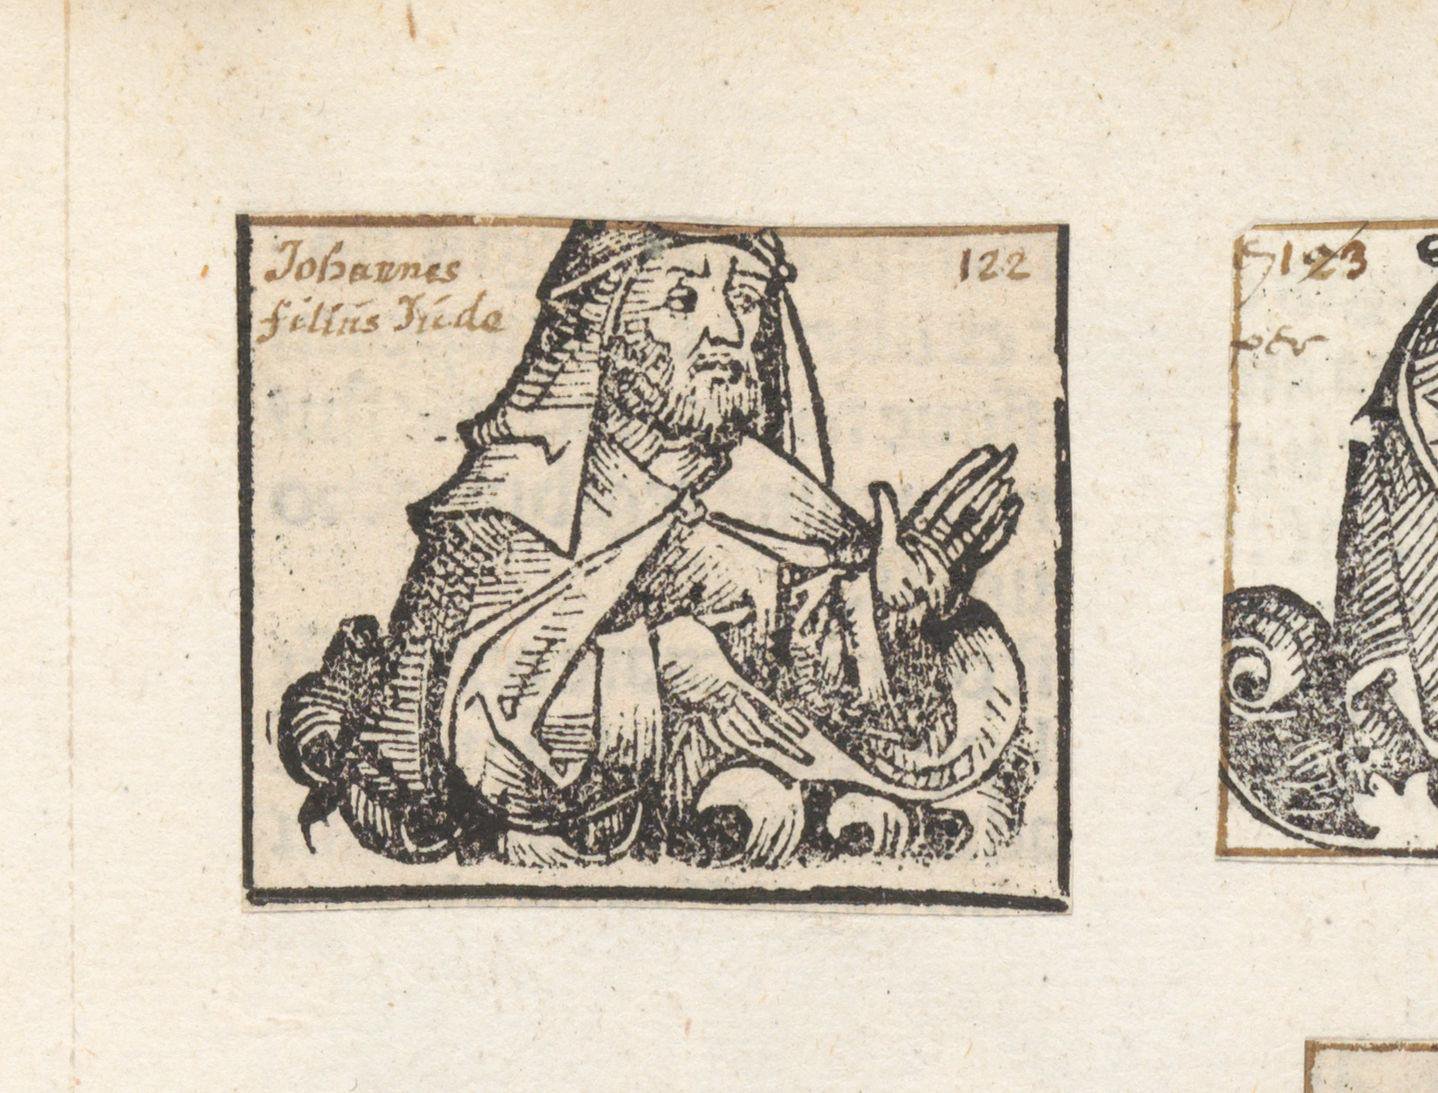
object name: book illustration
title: Liber Chronicarum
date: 1493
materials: paper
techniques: woodcut, pasting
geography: nuremberg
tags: persons from the old testament (not in biblical context, nor occurring in legendary/historical extensions included in division 71)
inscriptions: inscription: ‘Johannes fillius Juda / 122’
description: Een bloemkelk met een man met priestertulband, naar rechts gekeerd. De voorstelling is een fragment van de lijn van de priesters van Israël in de Liber Chronicarum. De tekst in deze Neurenbergkroniek identificeert de man als Jonahan, zoon van Jojada. De prent maakt deel uit van een album.